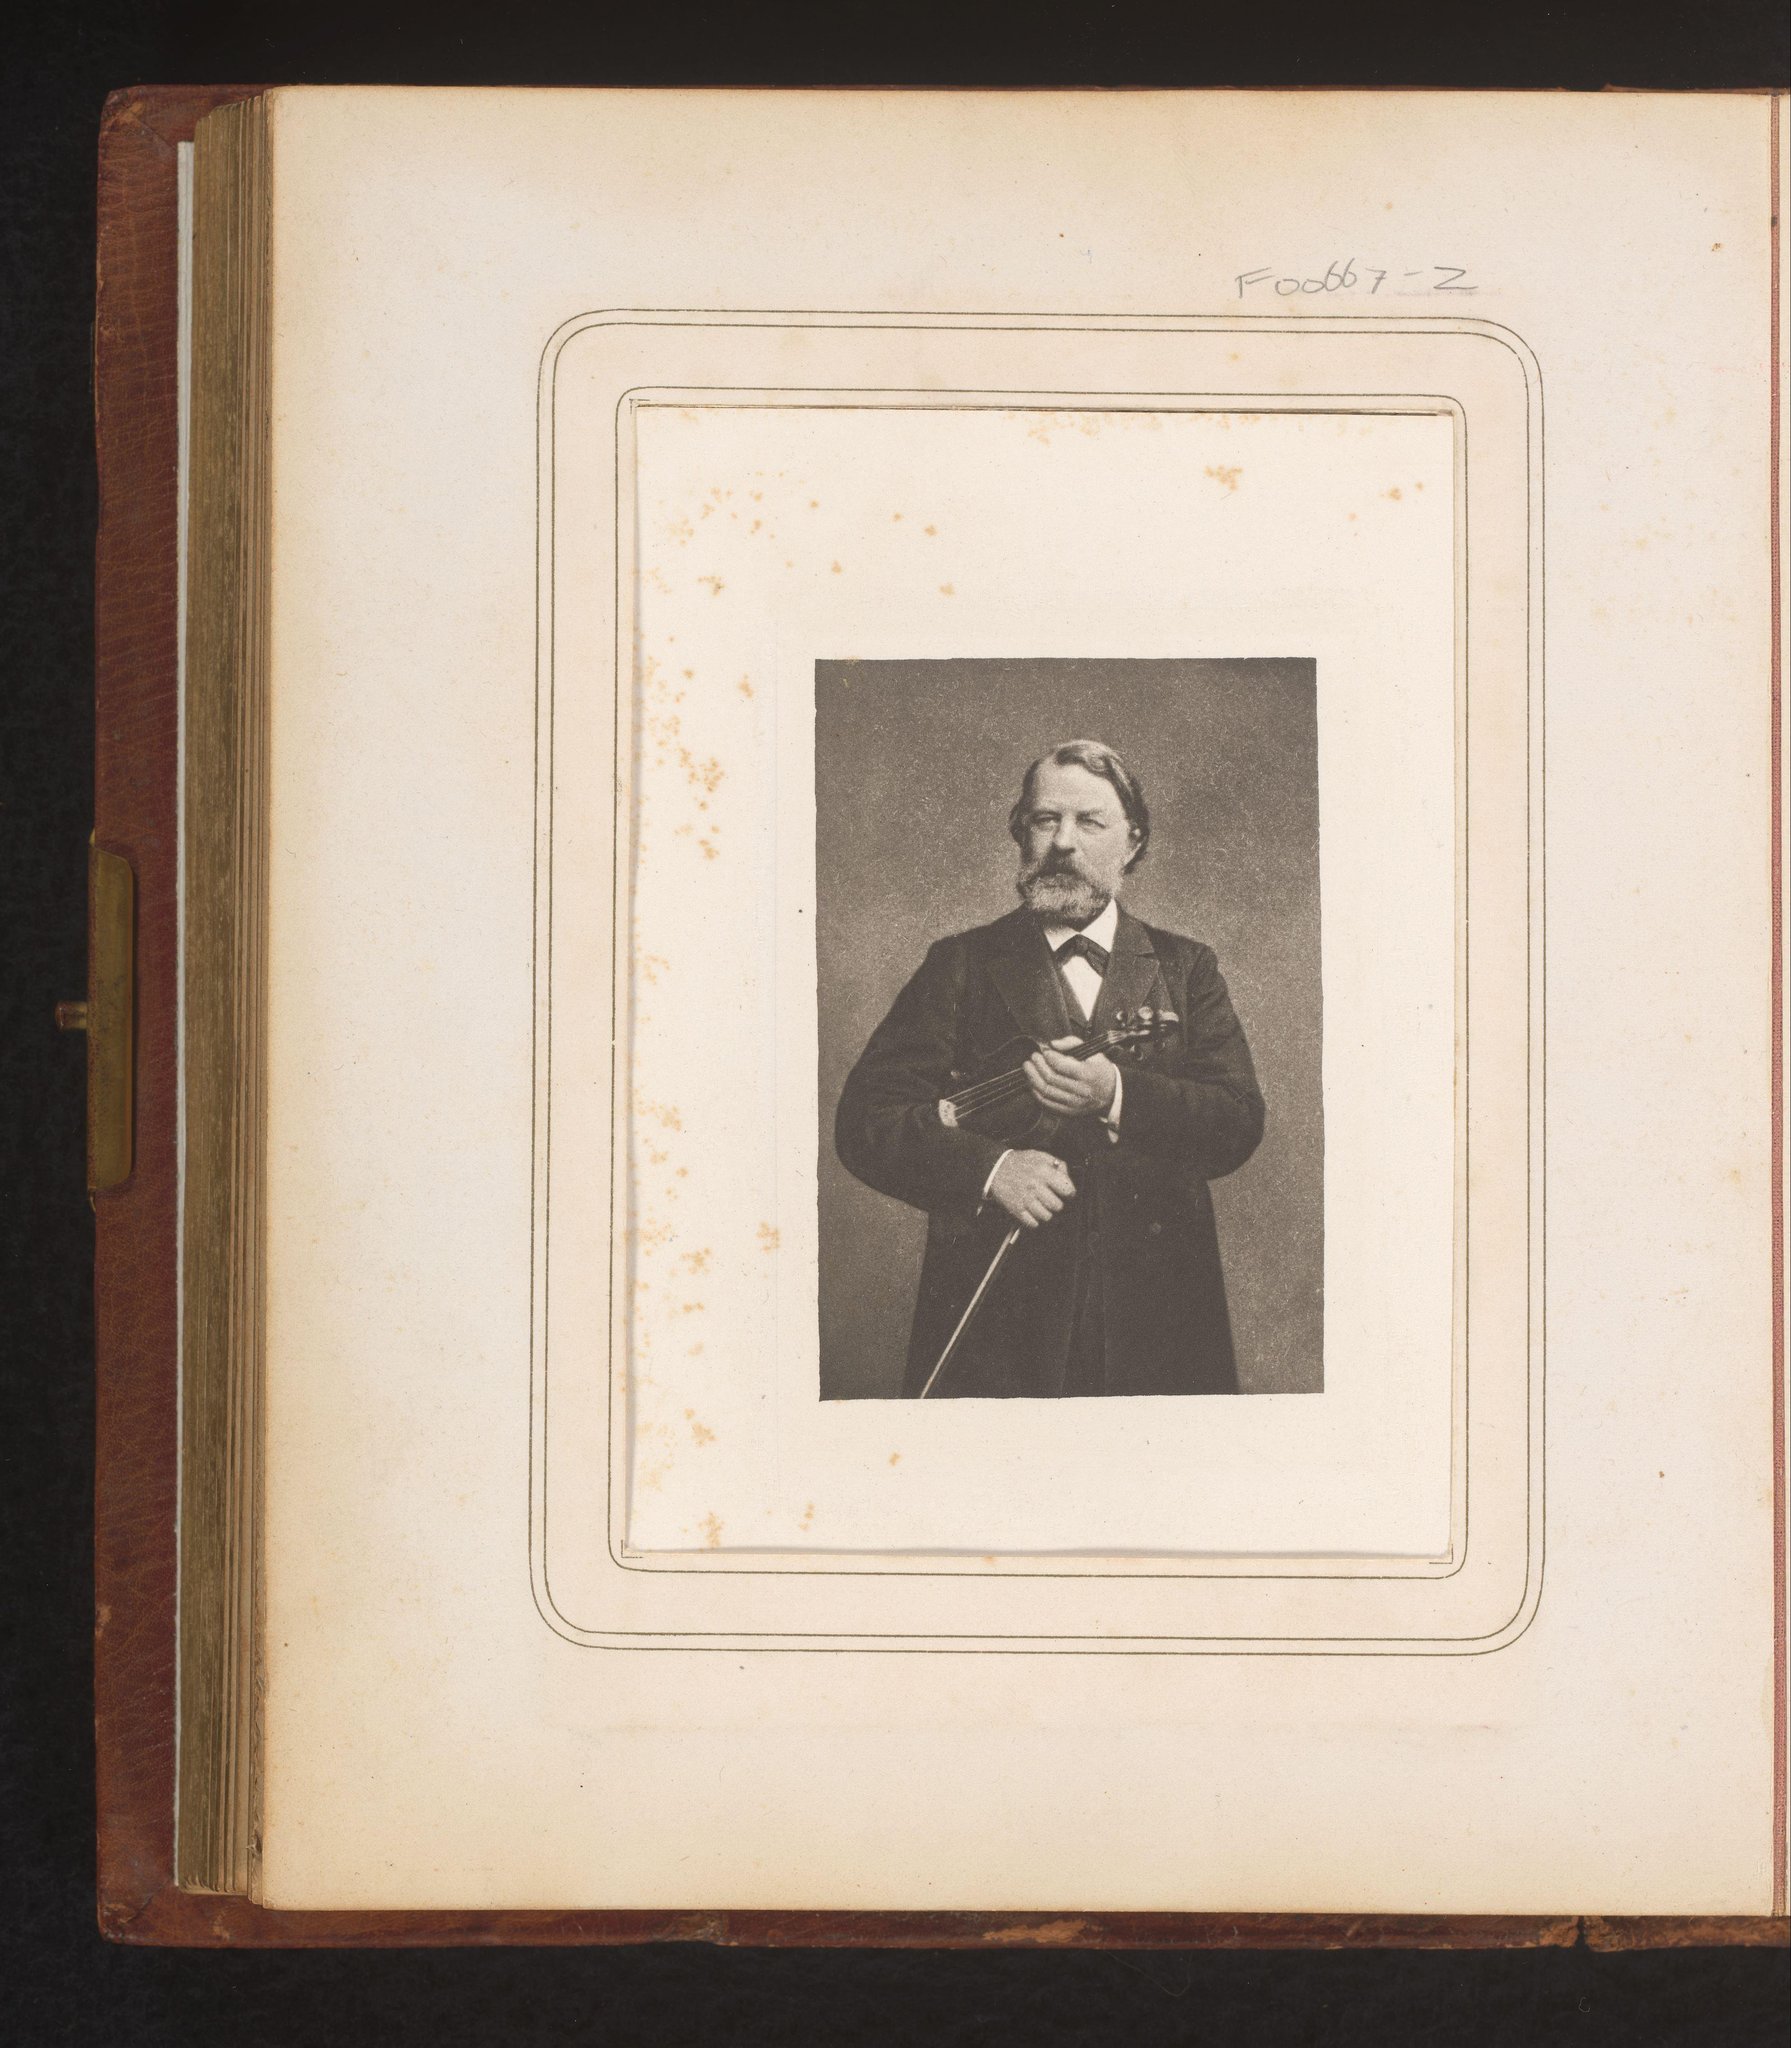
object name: album leaf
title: Portret van Joseph Joachim met viool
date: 1875-1890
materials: paper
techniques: photoaquatint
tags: historical persons, violin, fiddle, portrait of composer